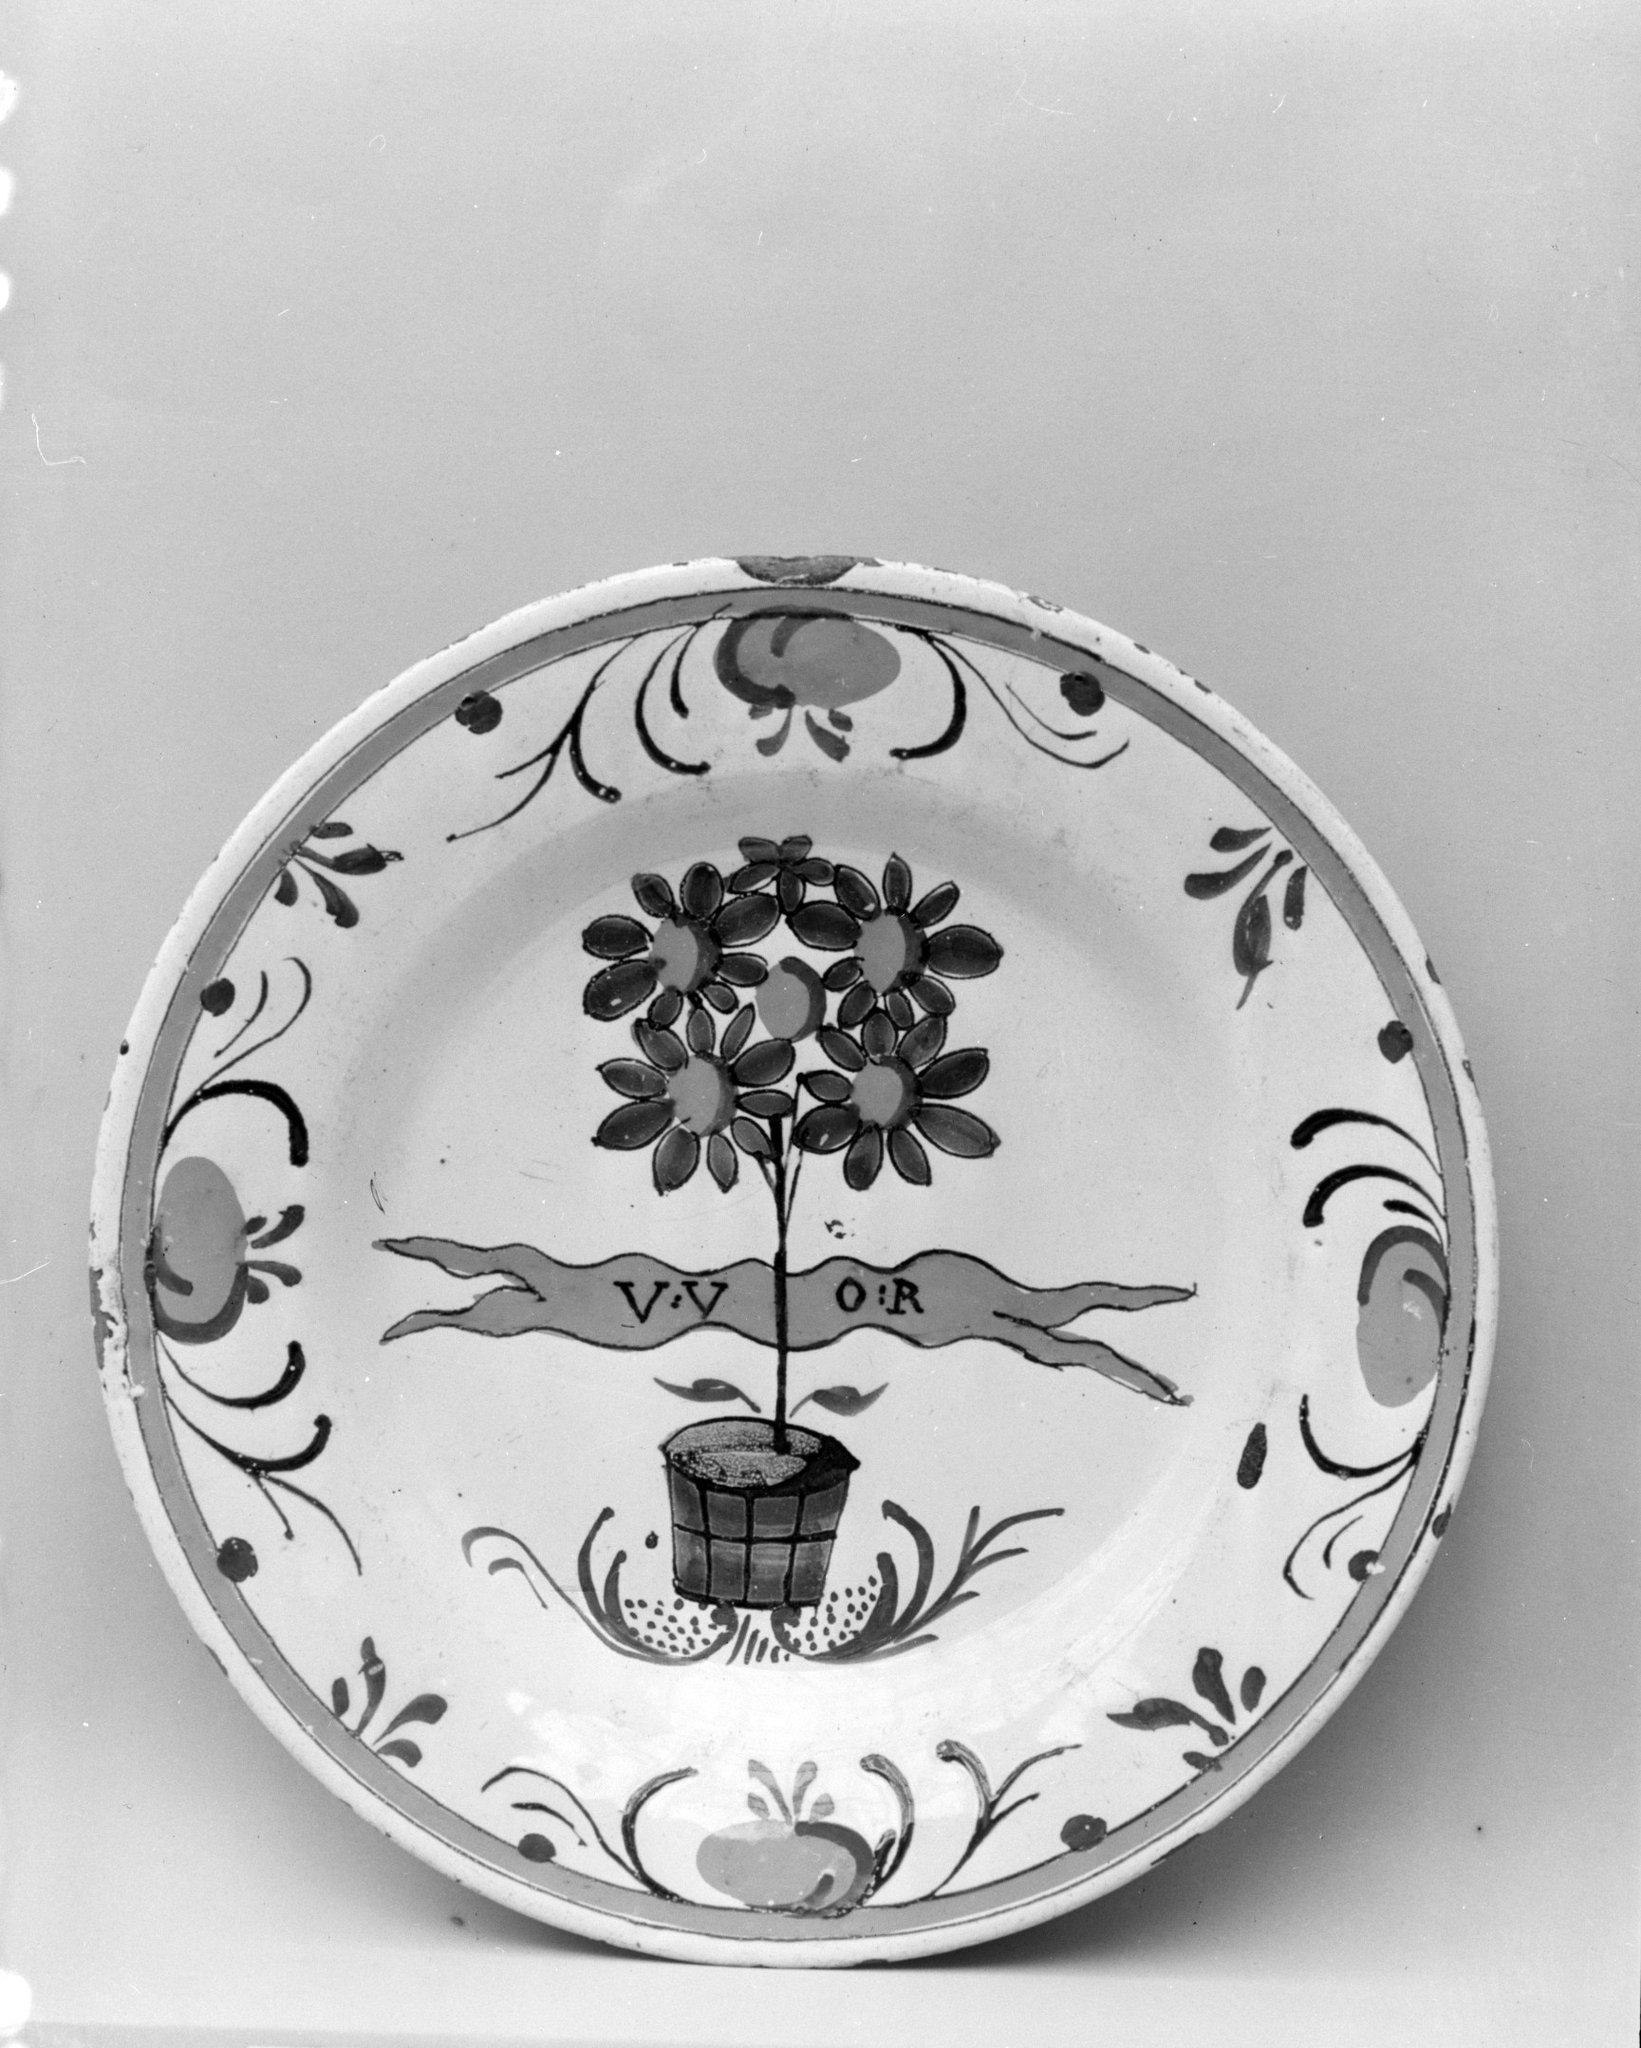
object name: plate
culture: dutch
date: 1700-1800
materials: earthenware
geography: netherlands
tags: flowers